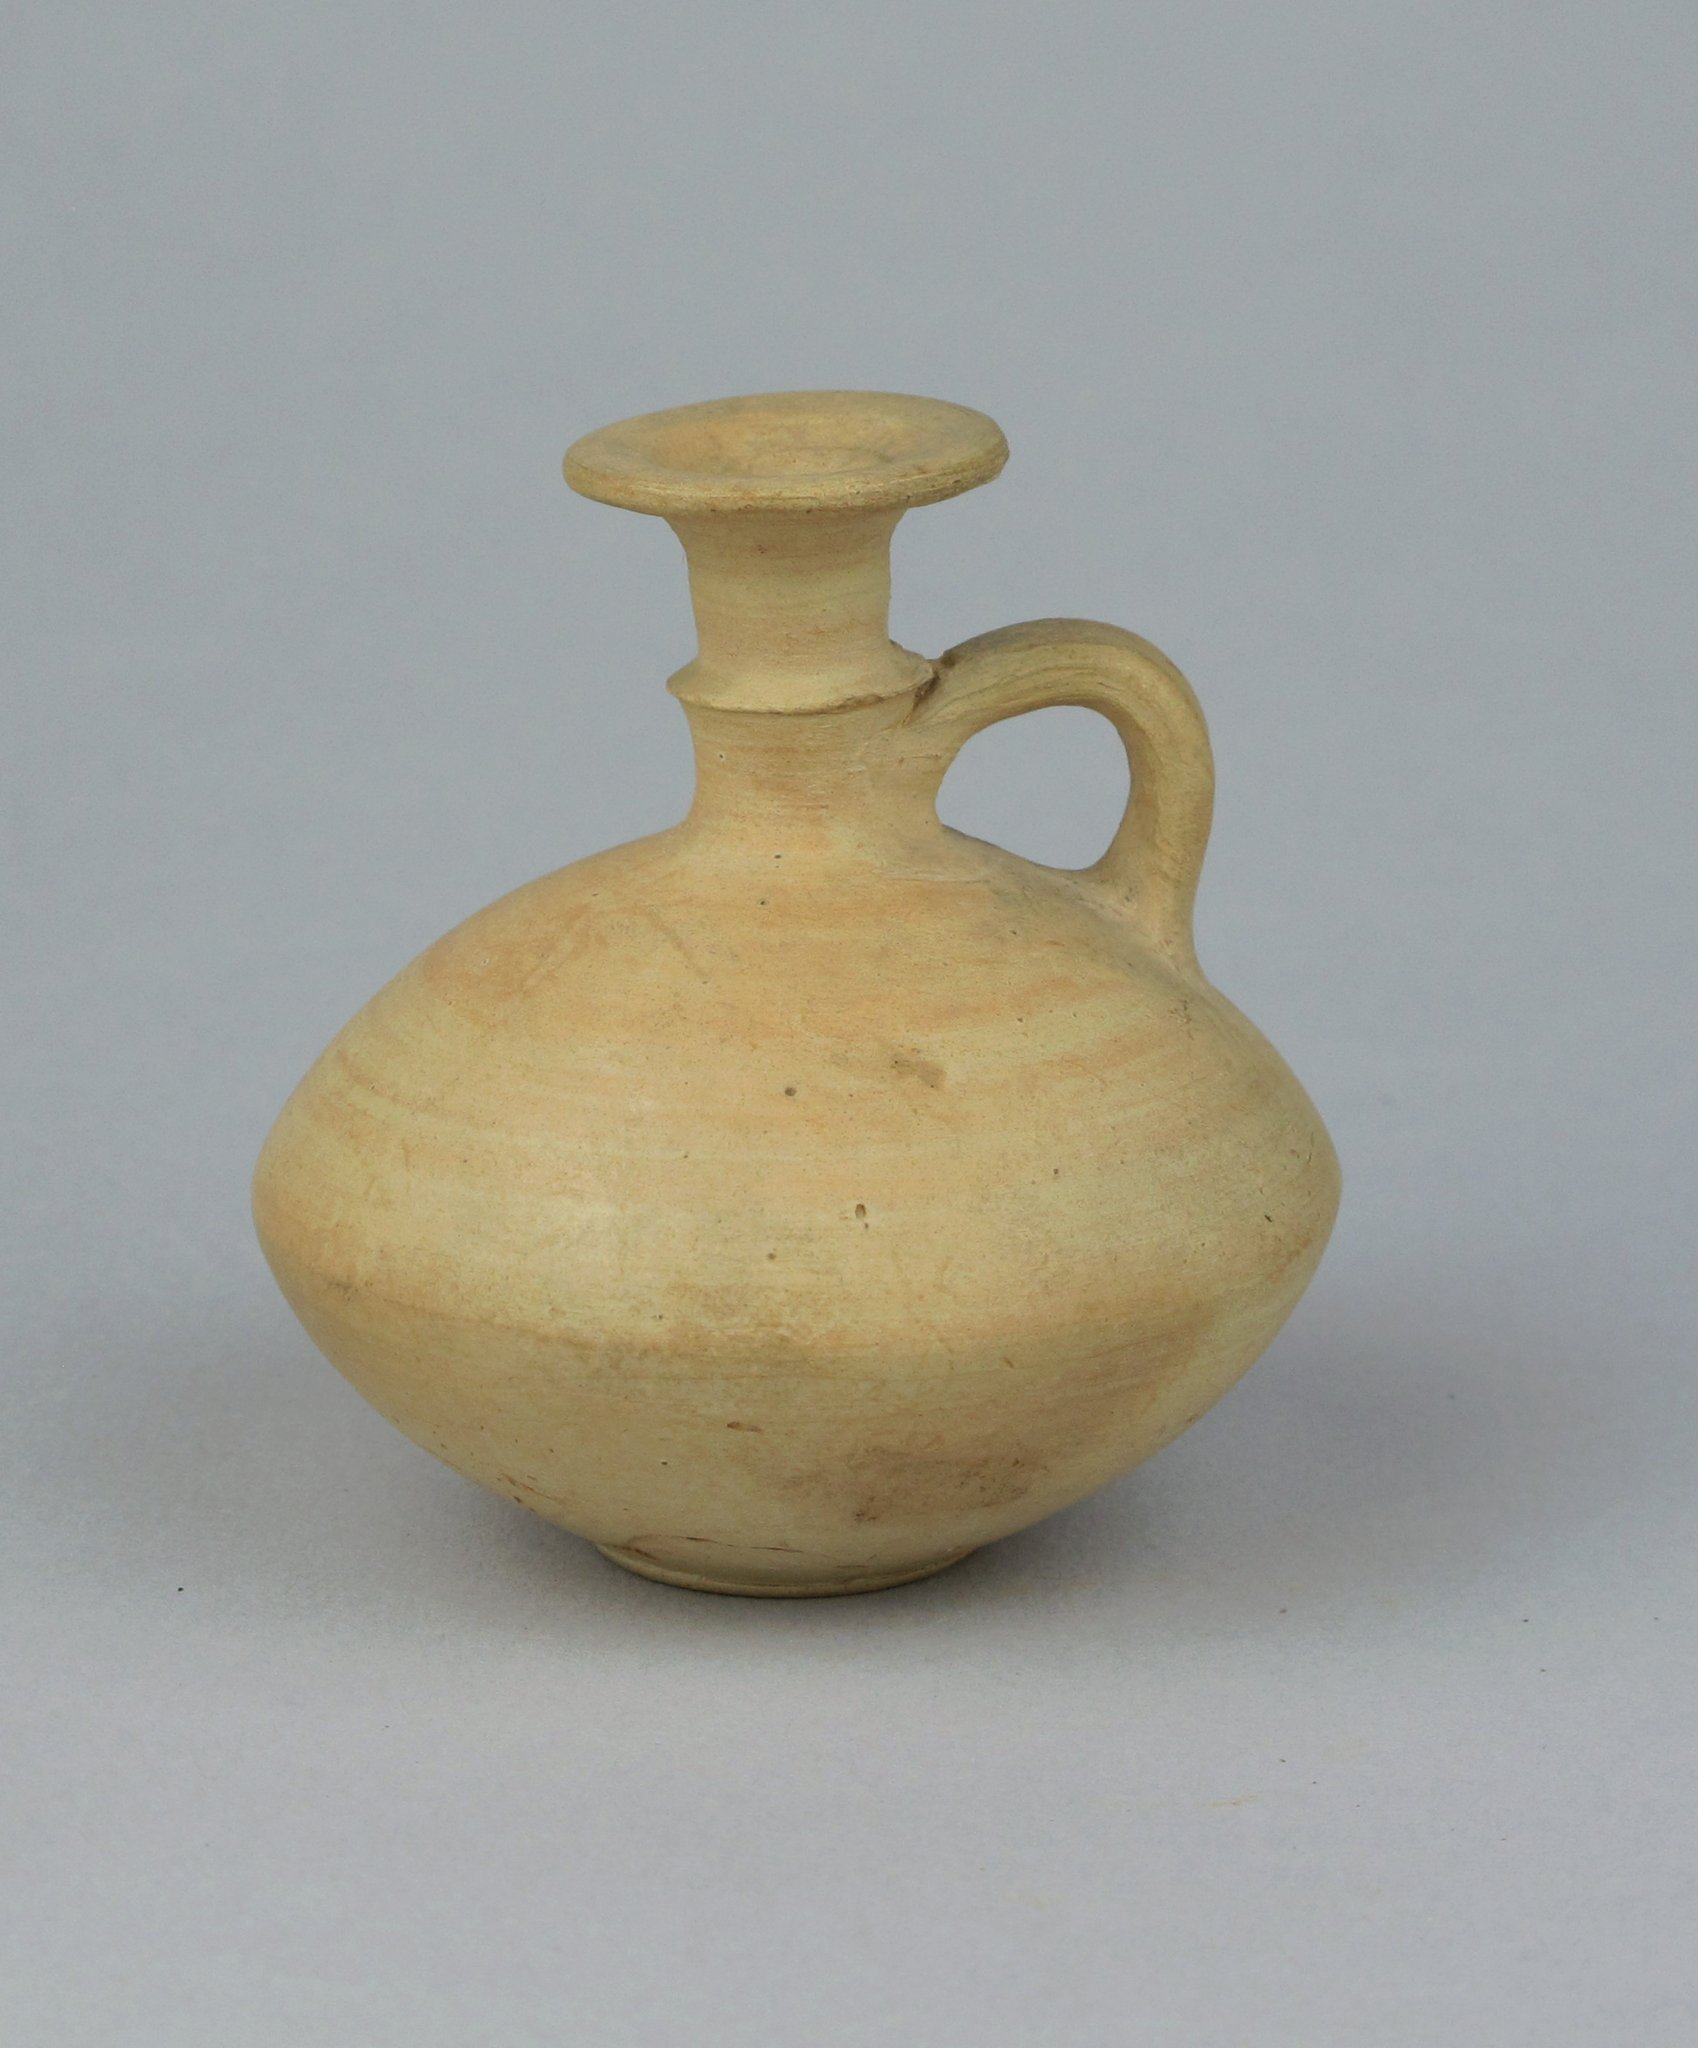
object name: juglet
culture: cypriot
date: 600-400 BCE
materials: terracotta